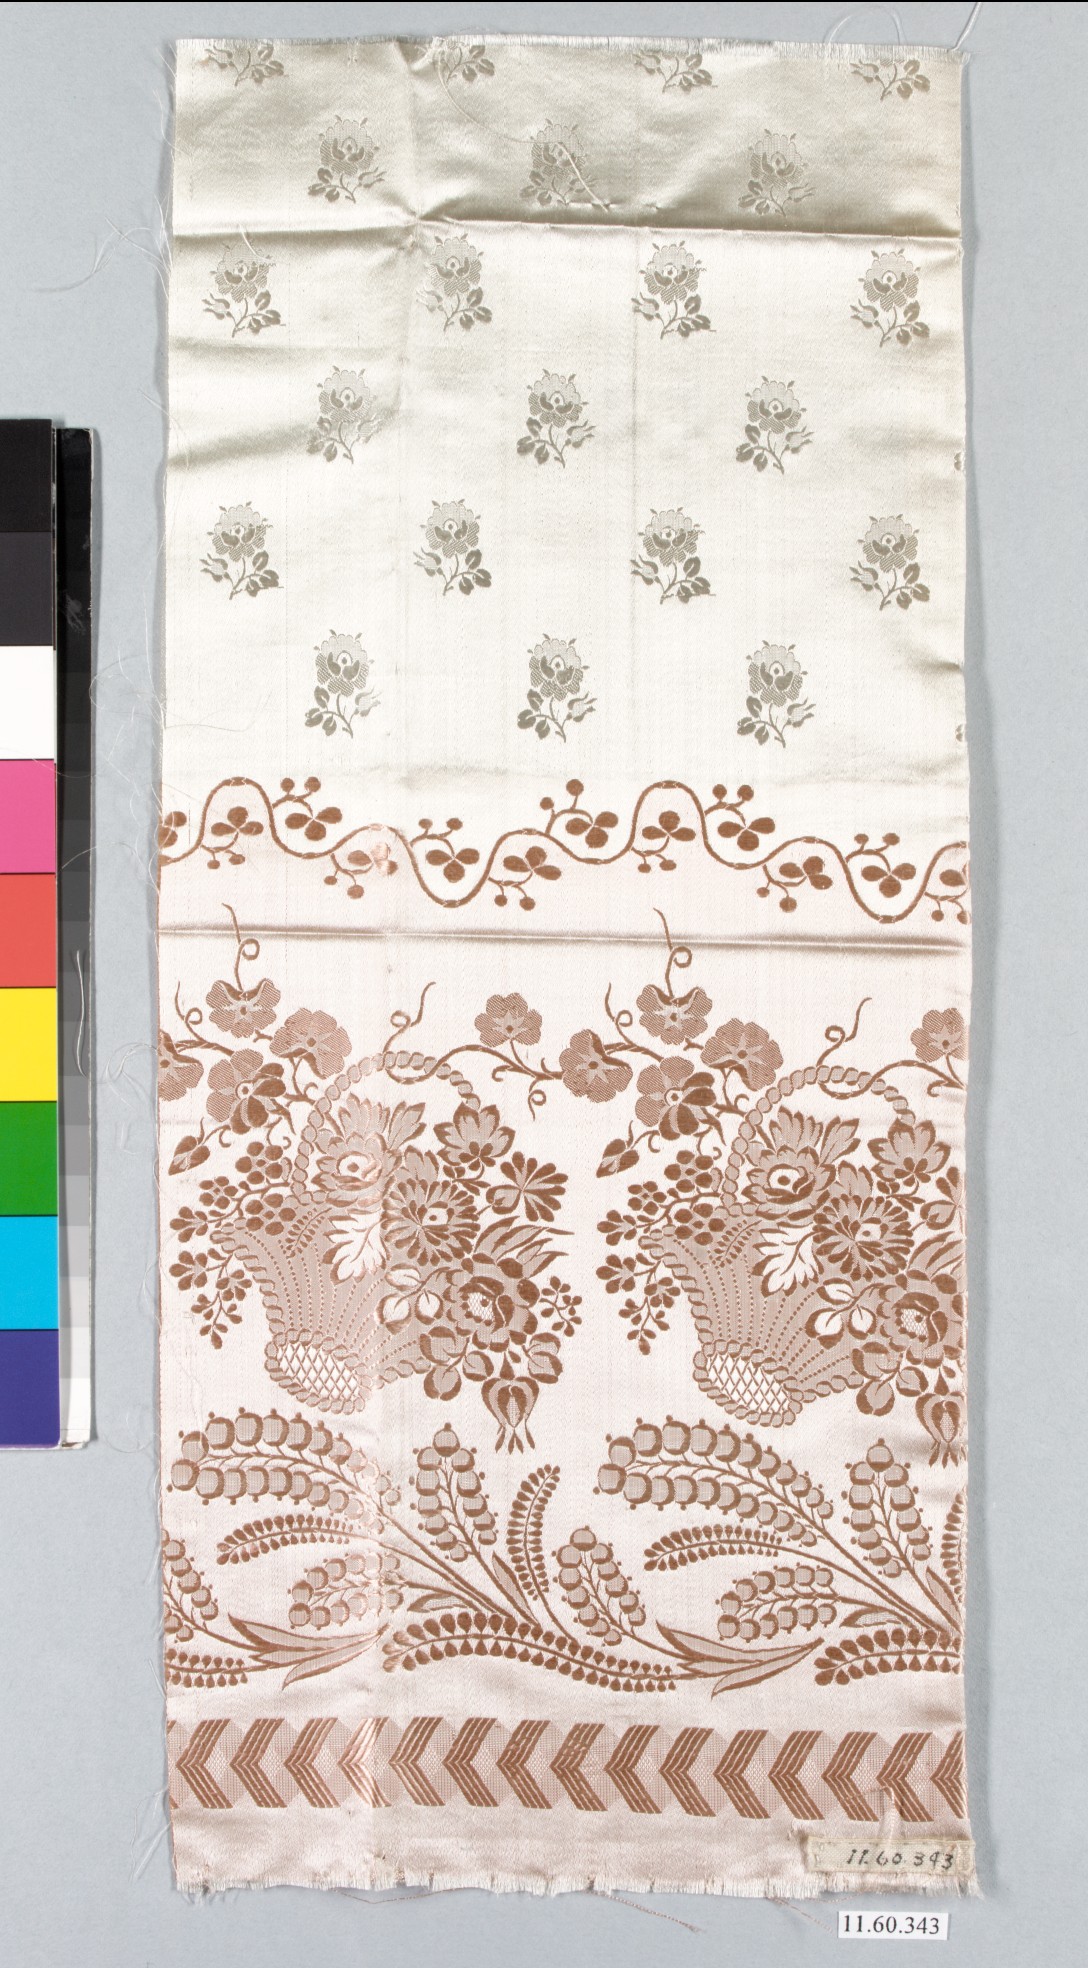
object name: fragment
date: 1801-1900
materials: silk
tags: flowers,leaves